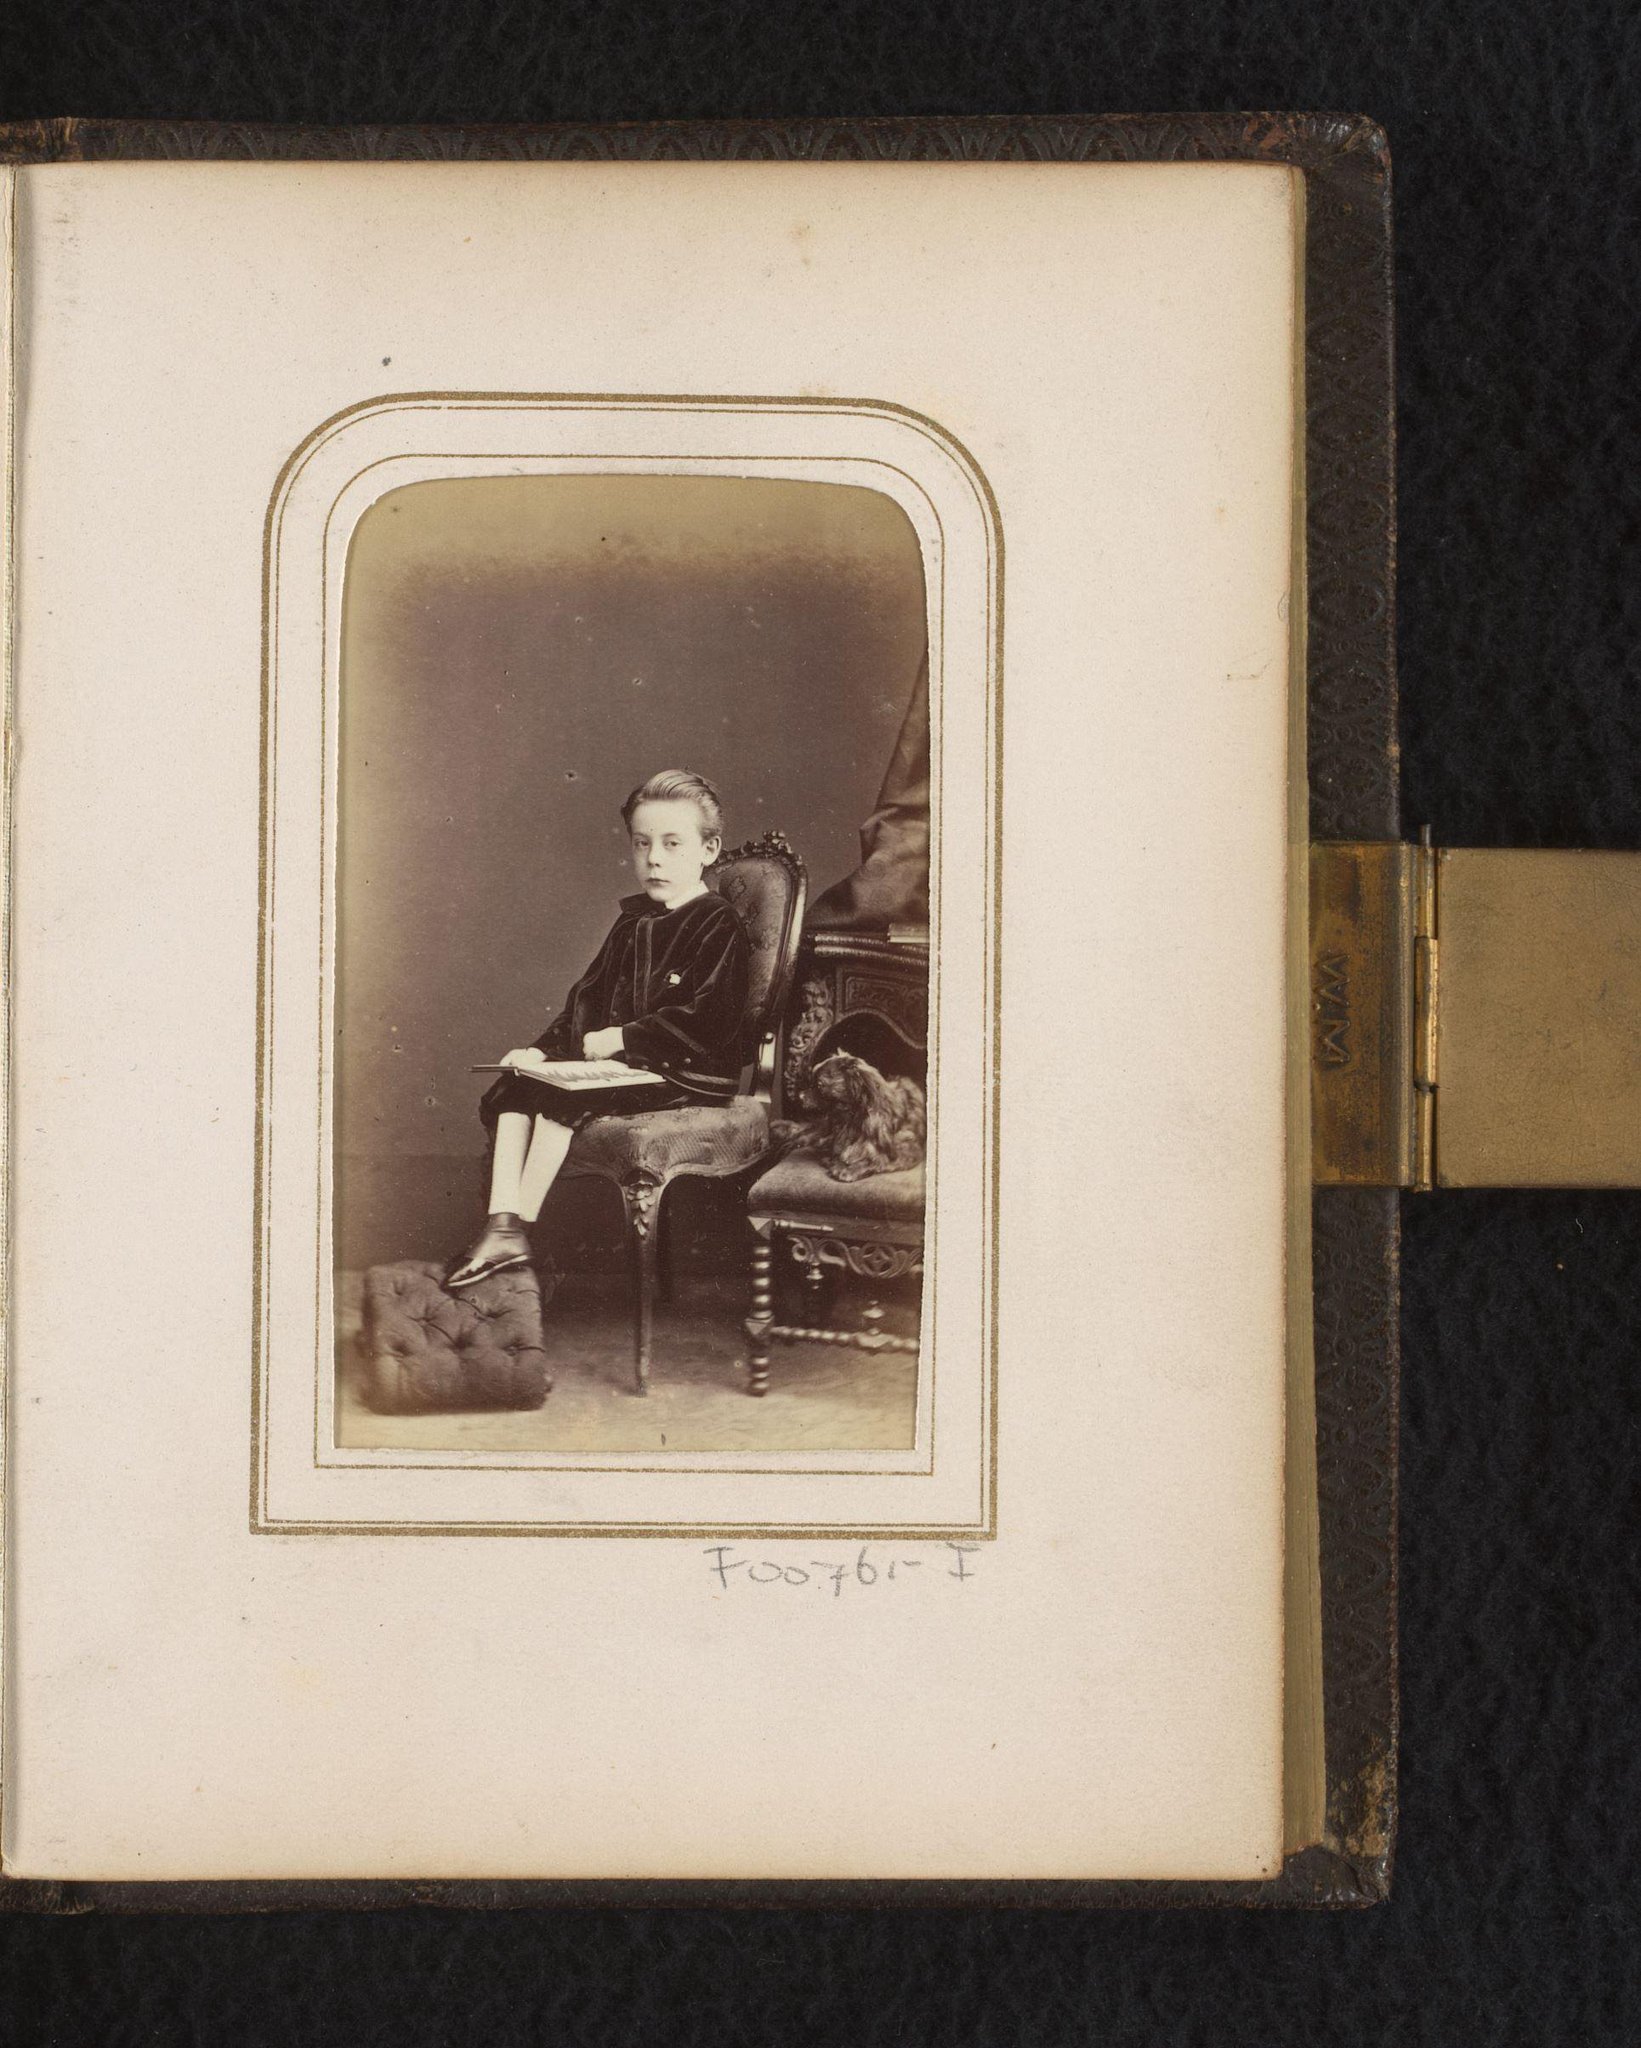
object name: album leaf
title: Portret van een zittende jongen met hond en boek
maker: henry maull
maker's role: fotograaf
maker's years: 1829-1914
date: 1854-1865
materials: cardboard, photographic support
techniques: albumen print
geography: london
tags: boy (child between toddler and youth), dog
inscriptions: number: ‘88901’, inscription: ‘Maull & Co/ Photographers and Miniature Painters/ 187A Piccadilly and 62, Cheapside/ London’